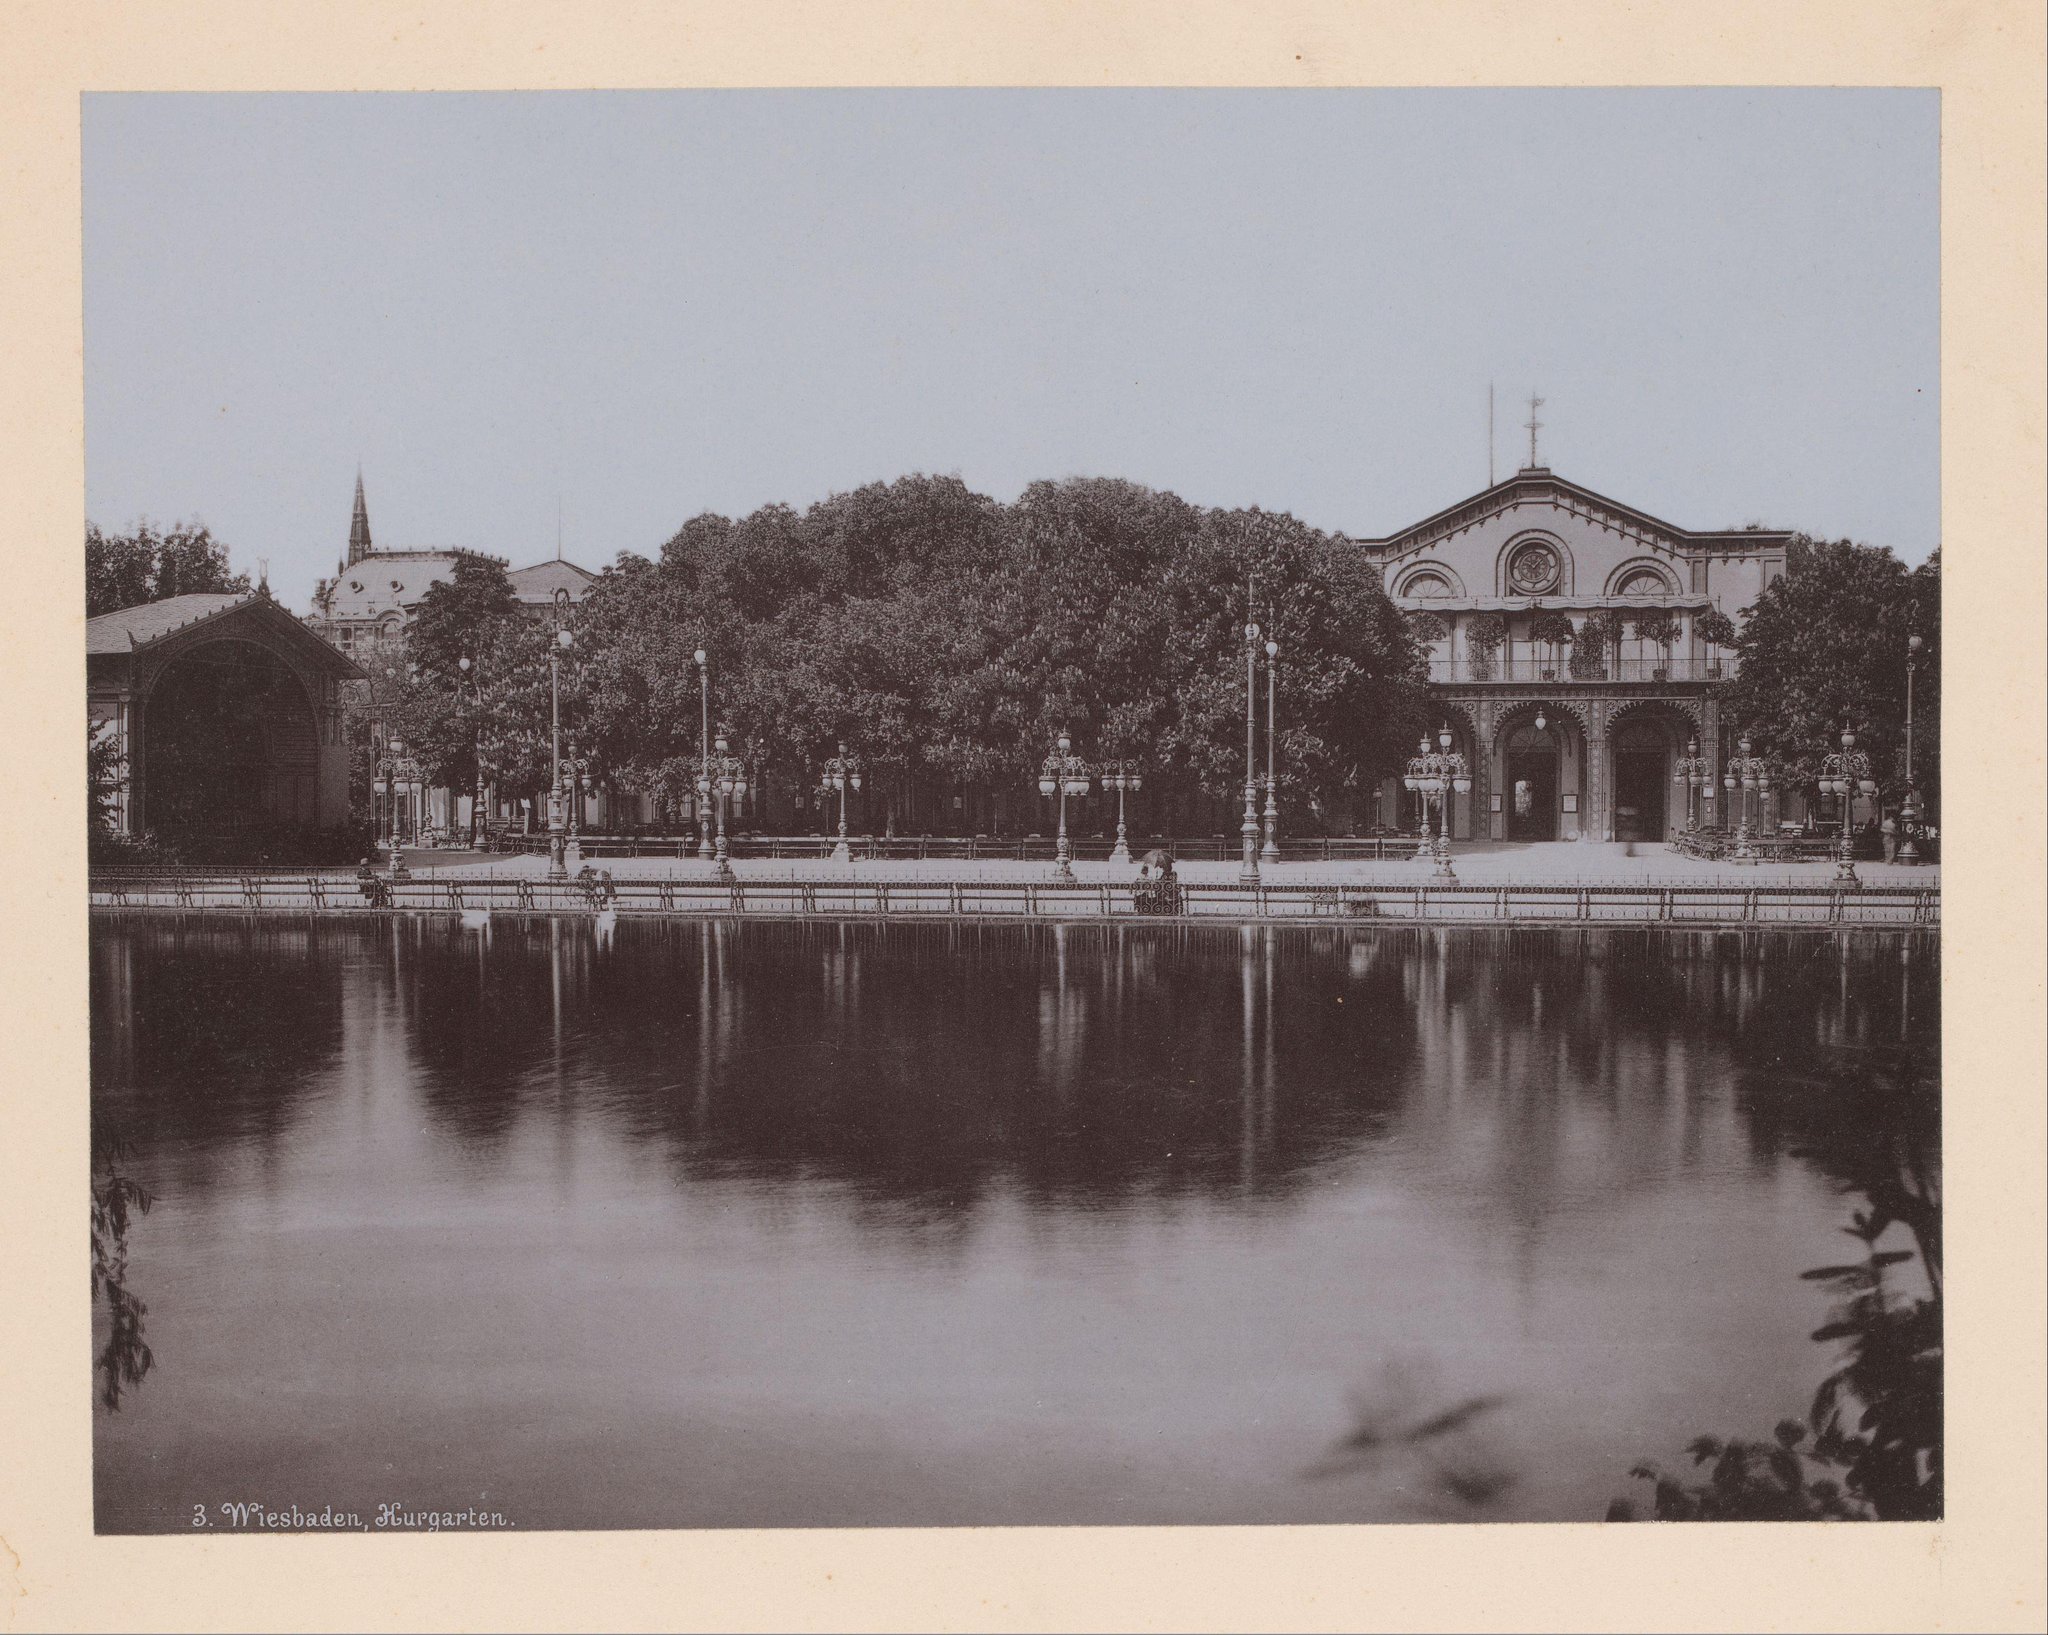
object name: photograph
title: Kurgarten, Wiesbaden, Duitsland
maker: Anonymous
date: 1880-1900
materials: cardboard, paper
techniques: photograph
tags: wiesbaden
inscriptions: inscription: ‘3. Wiesbaden, Kurgarten.’